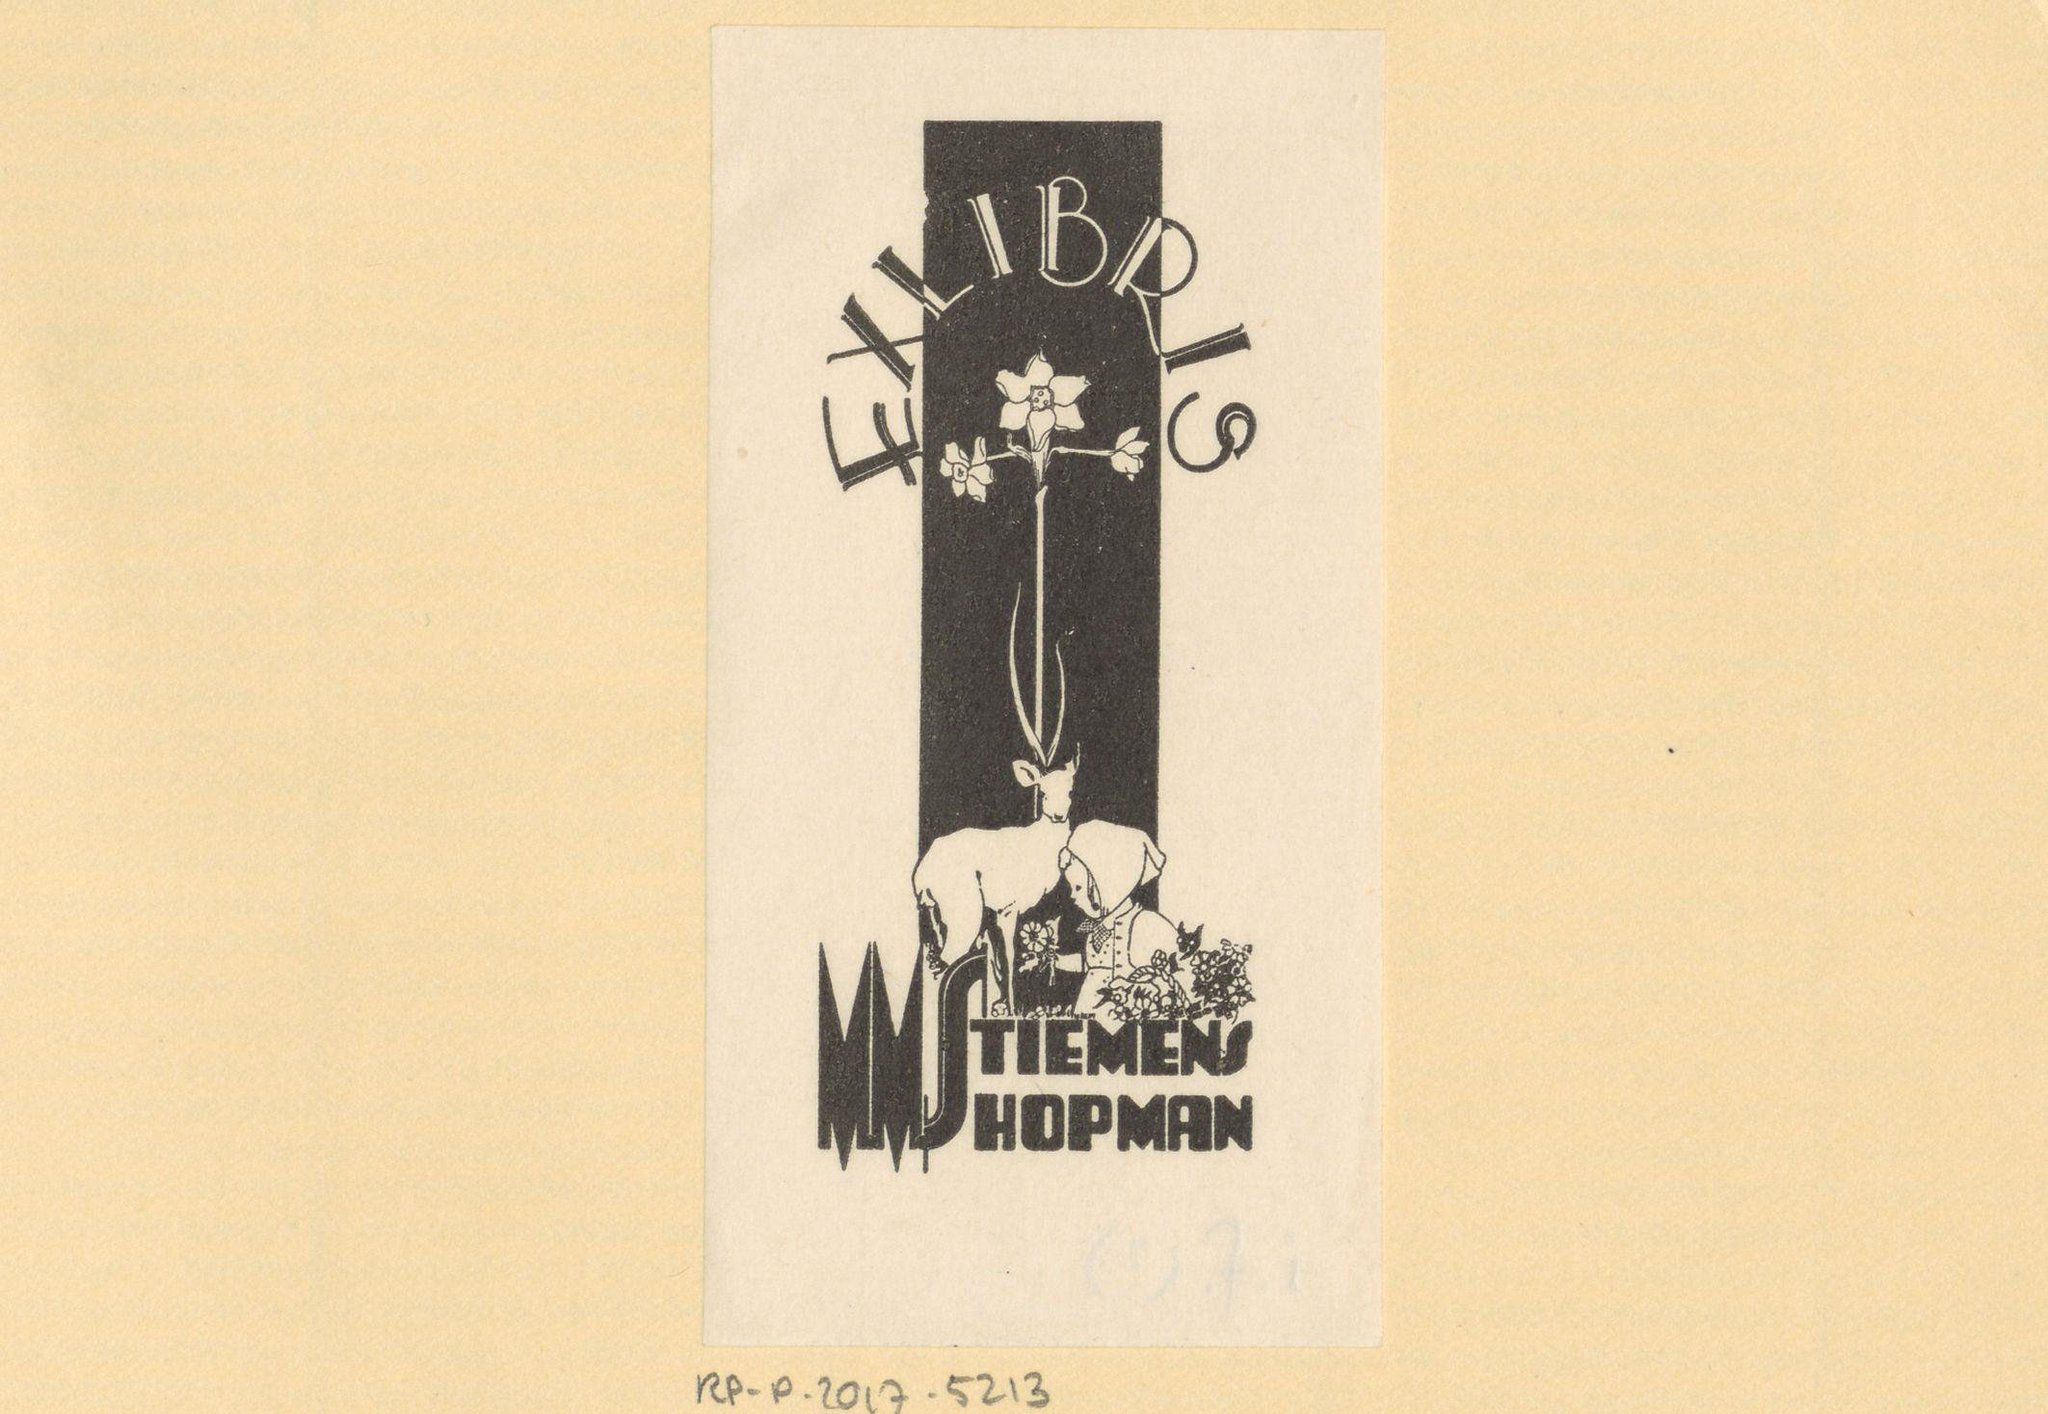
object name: bookplate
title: Ex libris van M.M. Stiemens-Hopman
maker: Anonymous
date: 1940-1959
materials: paper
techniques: printing block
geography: amsterdam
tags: amsterdam, hoofed animals: deer, the graphic arts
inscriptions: inscription: ‘i.f. (?)’